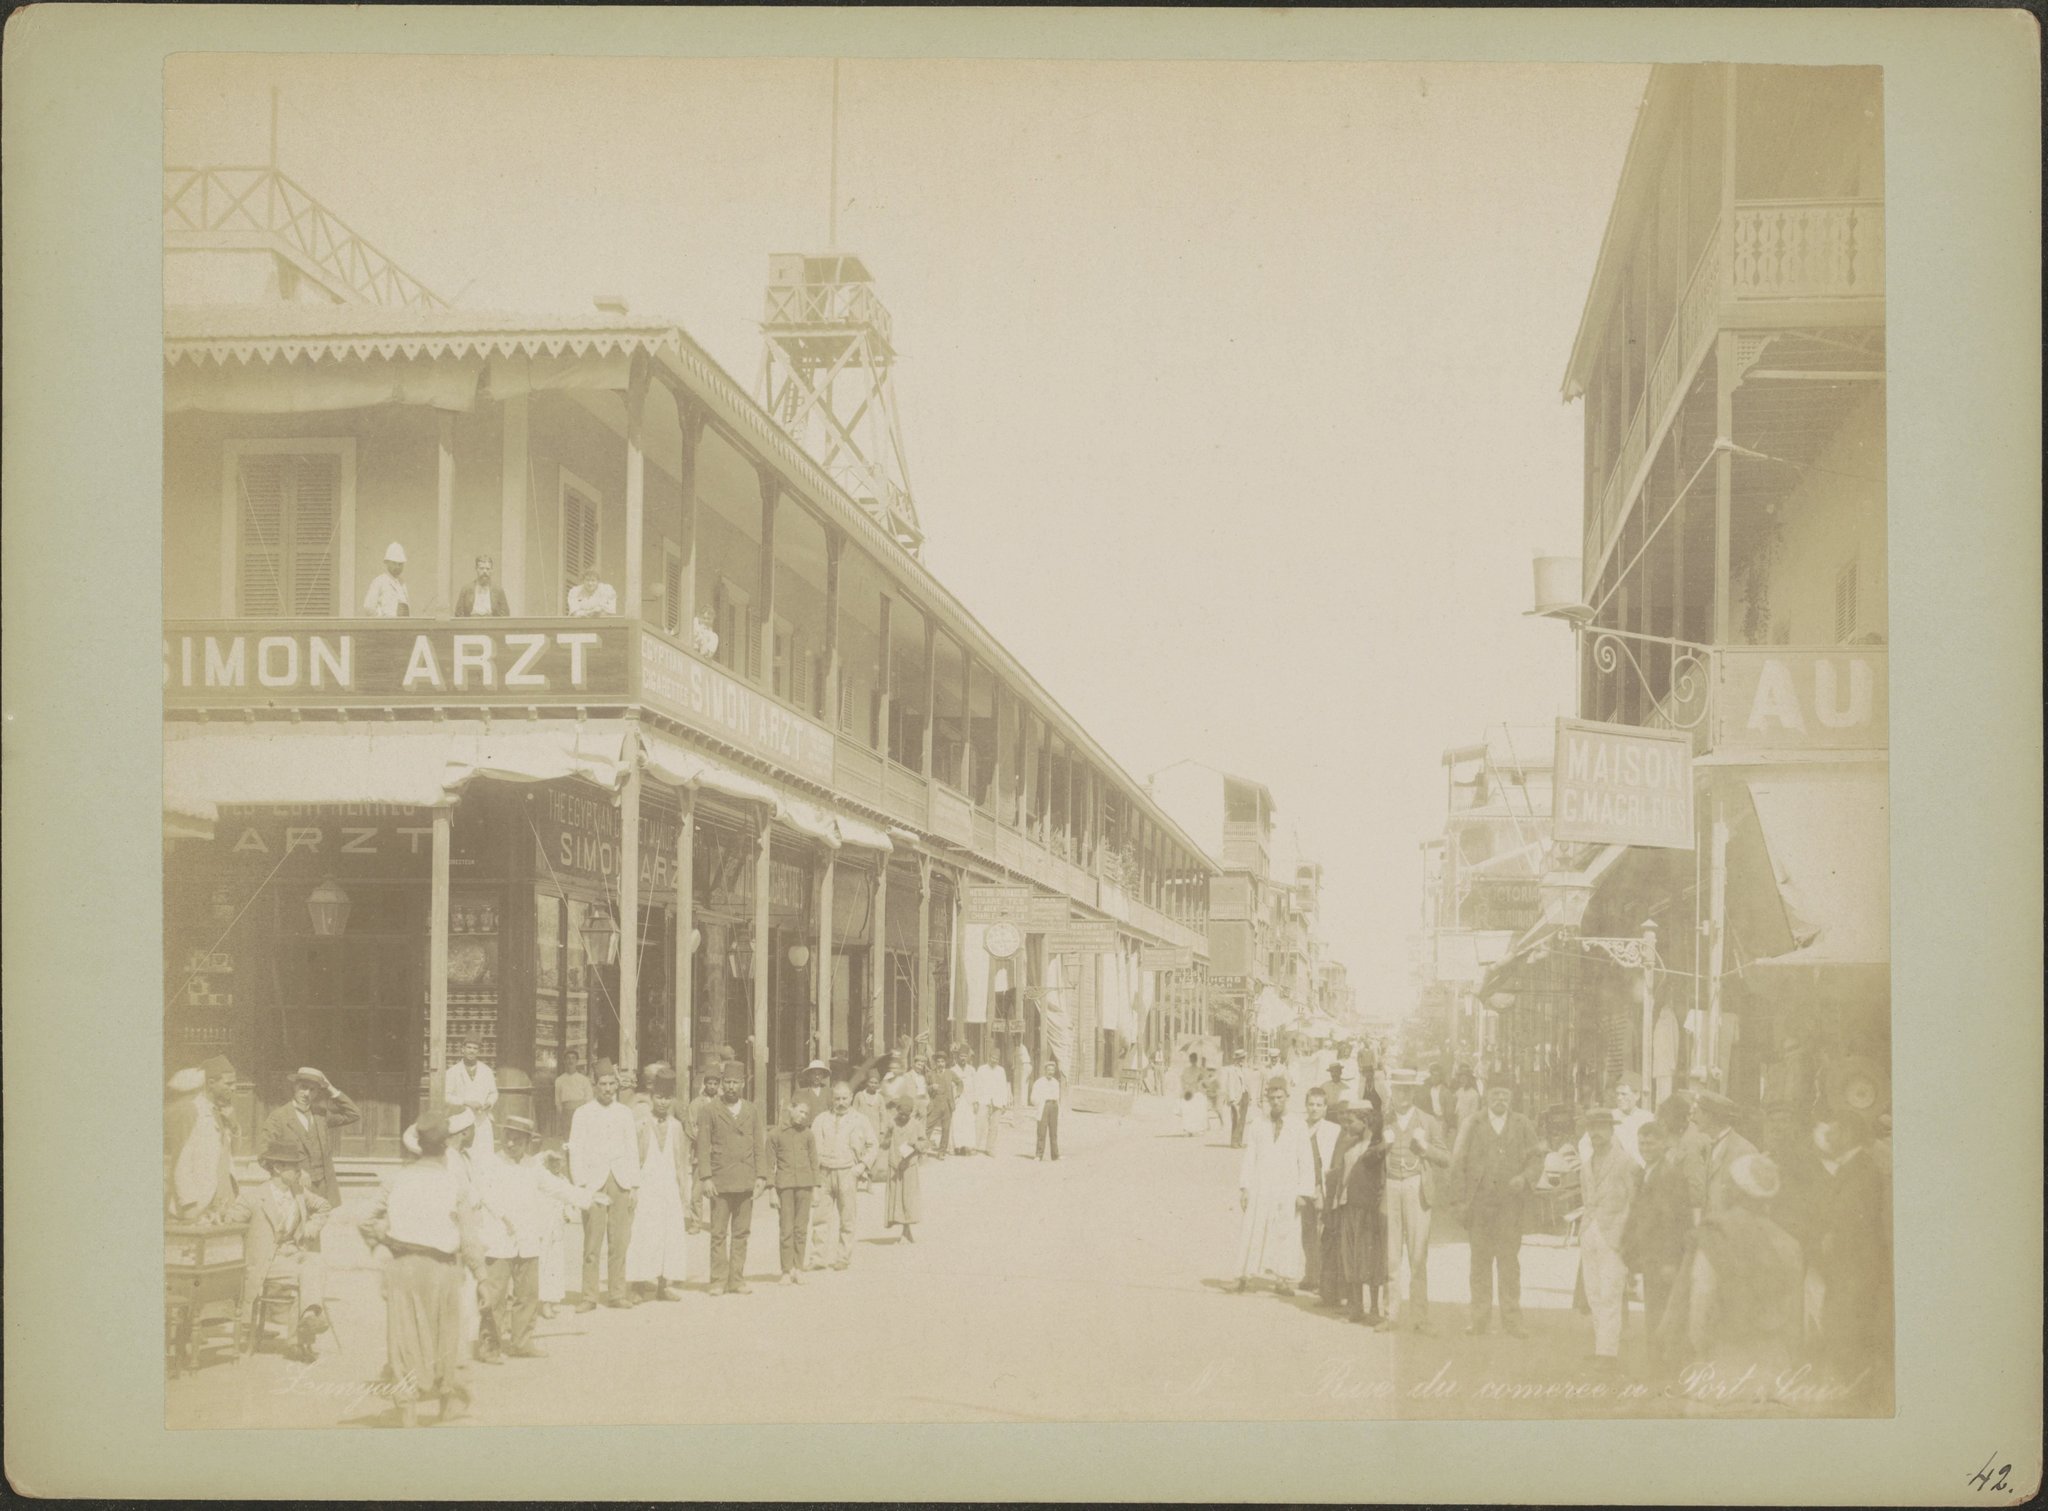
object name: album leaf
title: Rue du comerce a Port Said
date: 1870-1890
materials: cardboard, paper, photographic support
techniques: albumen print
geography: port said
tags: shop, store, street (+ city(-scape) with figures, staffage)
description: Onderdeel van Reisalbum met foto's van bezienswaardigheden in Marseille, Port Said, Aden, Bombay, Colombo, Singapore en Nederlands-Indië.